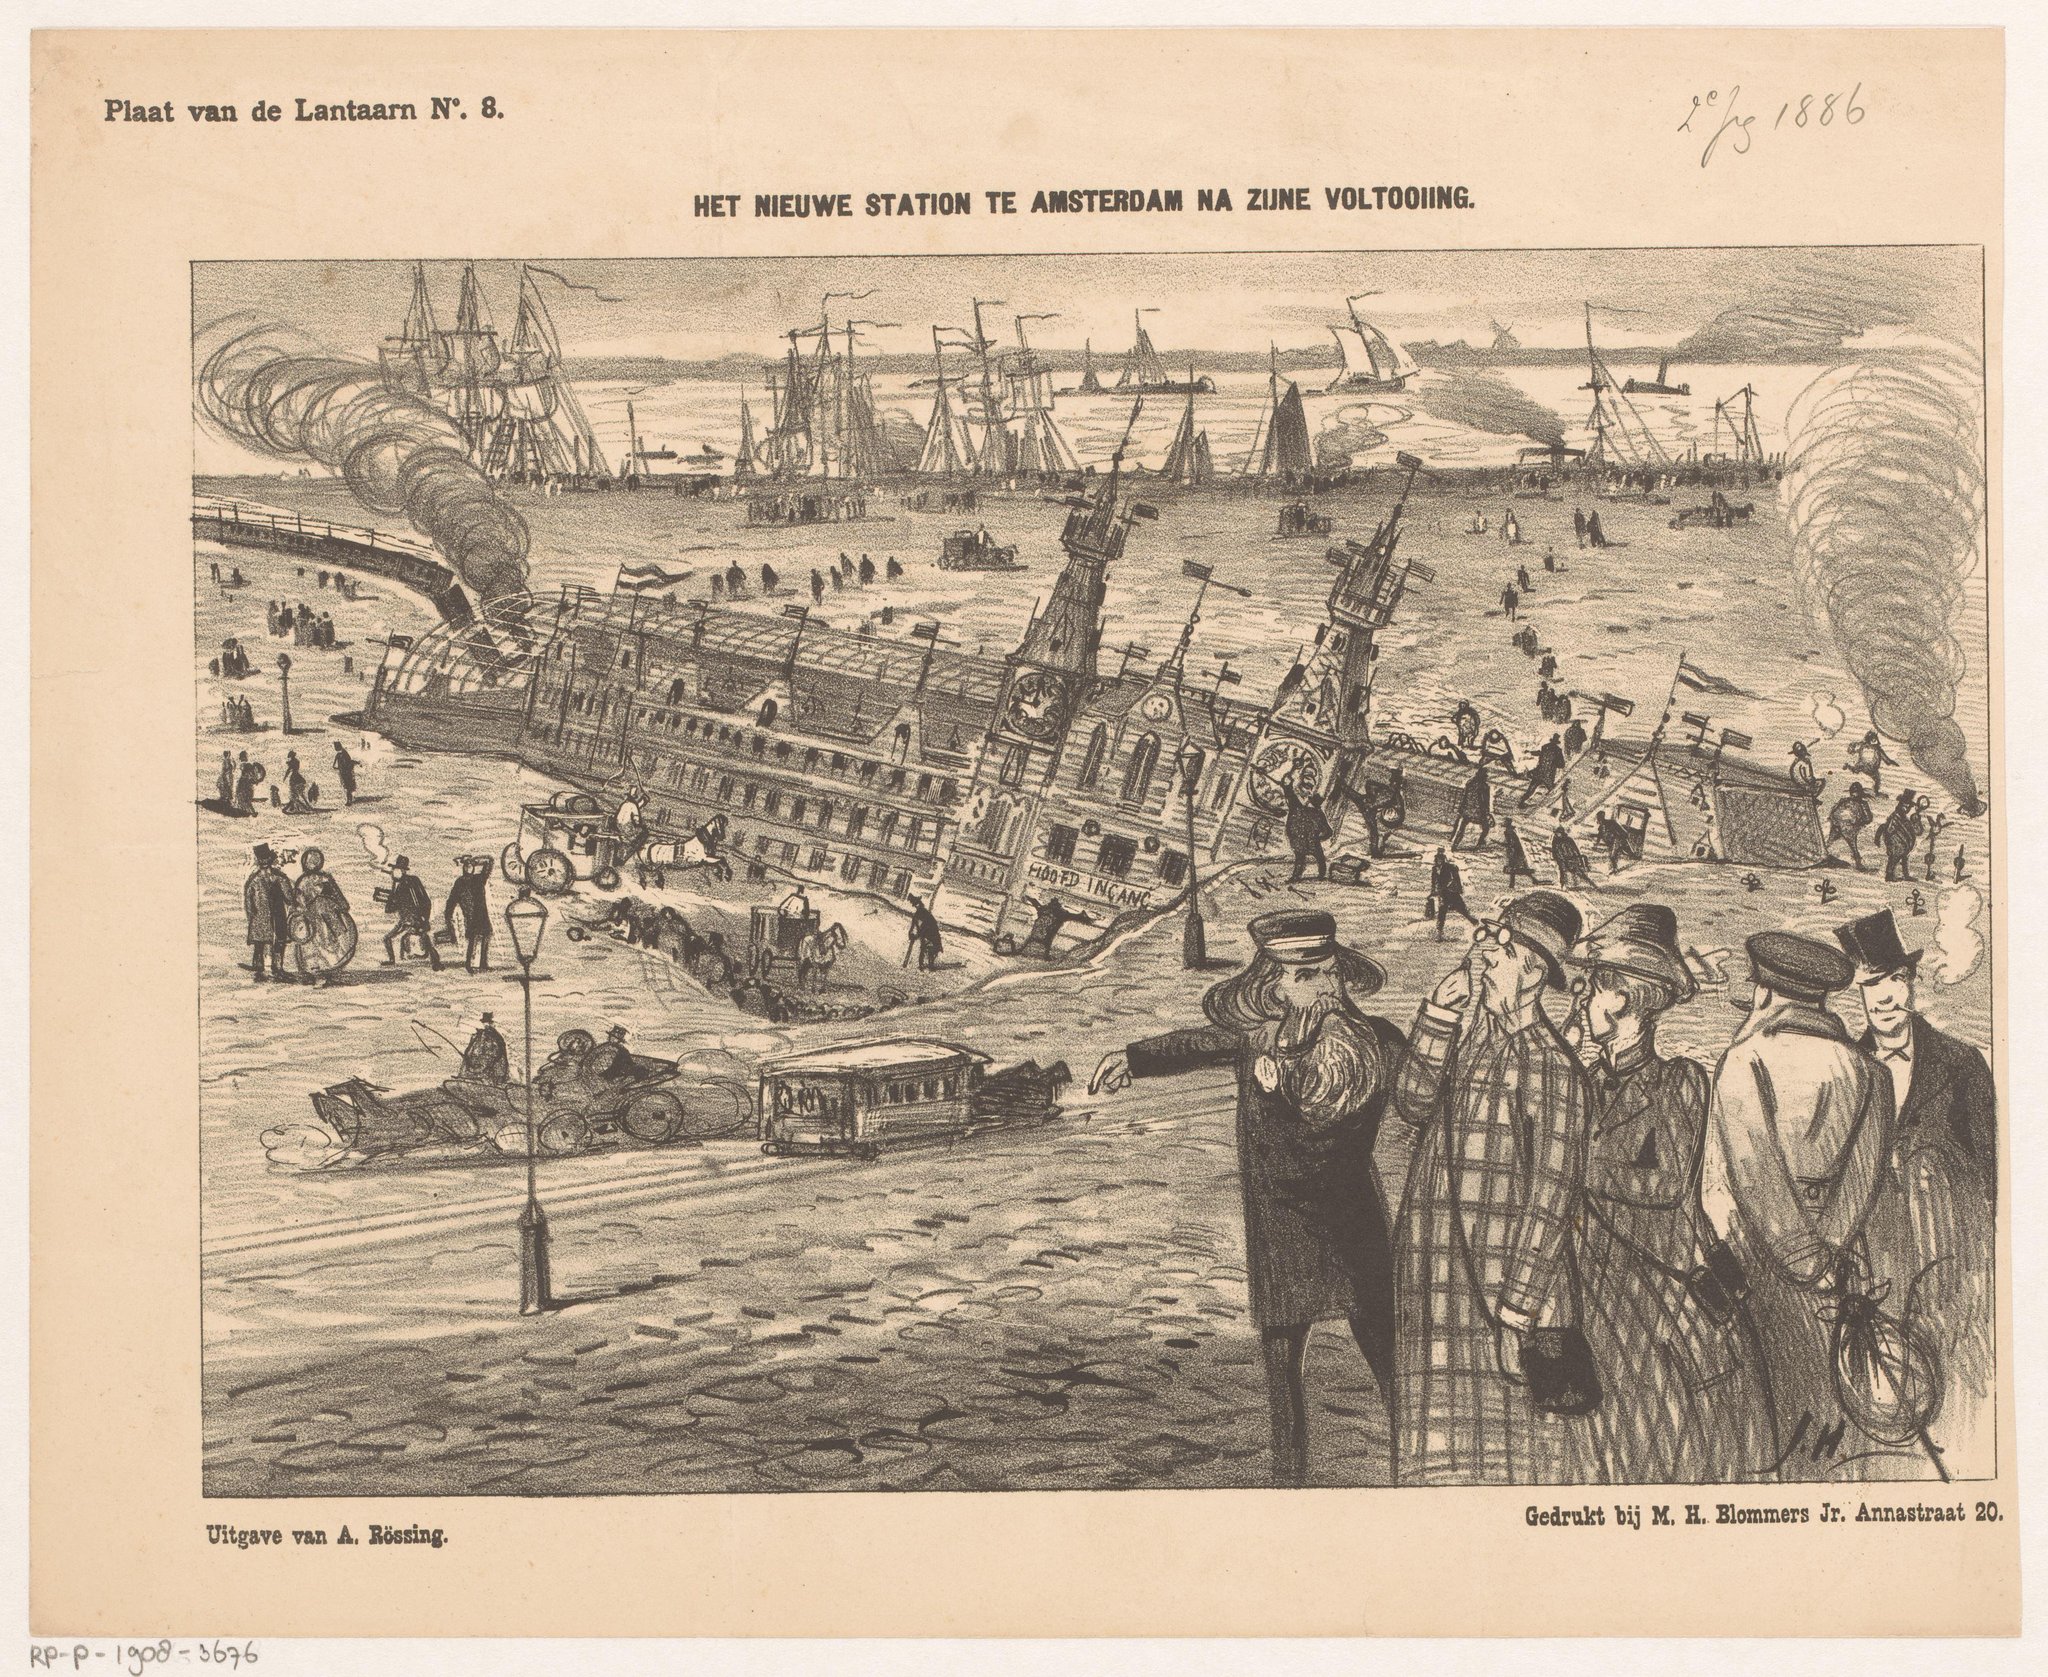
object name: print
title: Spotprent over het nieuwe treinstation in Amsterdam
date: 1886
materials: paper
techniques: lithograph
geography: netherlands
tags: draughtsman, pierre joseph hubert cuypers, station; shelter (railway, tramway), political caricatures and satires, amsterdam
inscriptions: collector's mark: Lugt 2228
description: De architect, Pierre Cuypers, staat naast een groepje toeschouwers. Hij draagt een conducteurspet. Achter hen zakt het station weg in de grond. Deze prent werd uitgegeven bij De Lantaarn.